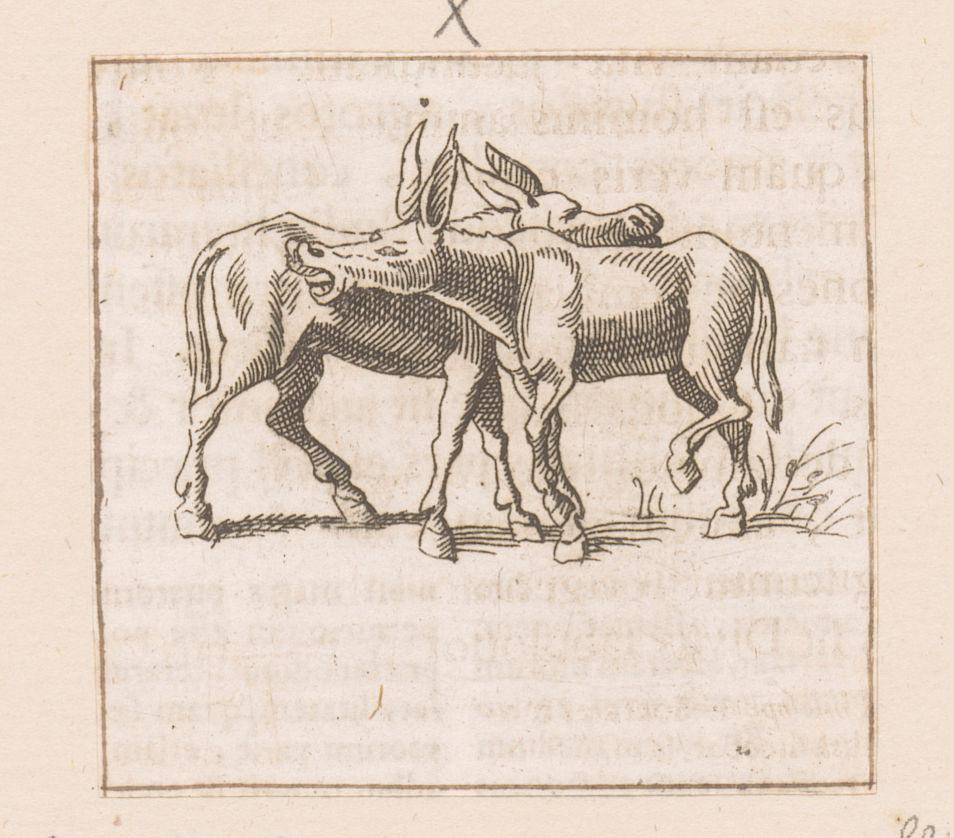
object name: book illustration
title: Twee ezels die elkaars rug krabben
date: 1516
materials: paper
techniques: etching, letterpress printing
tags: ass, donkey, folly, foolishness; 'pazzia', 'sciocchezza', 'stoltitia' (ripa)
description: Prent afkomstig uit: Erasmus, Desiderius. Morias enkomion (...). Bazel: Johann Rudolf Genath, 1676. De prenten hierin zijn naar tekeningen die Hans en Ambrosius Holbein maakten voor de theoloog Oswald Myconius in diens uitgave van de Moriae encomium (Lof der Zotheid) van 1516.